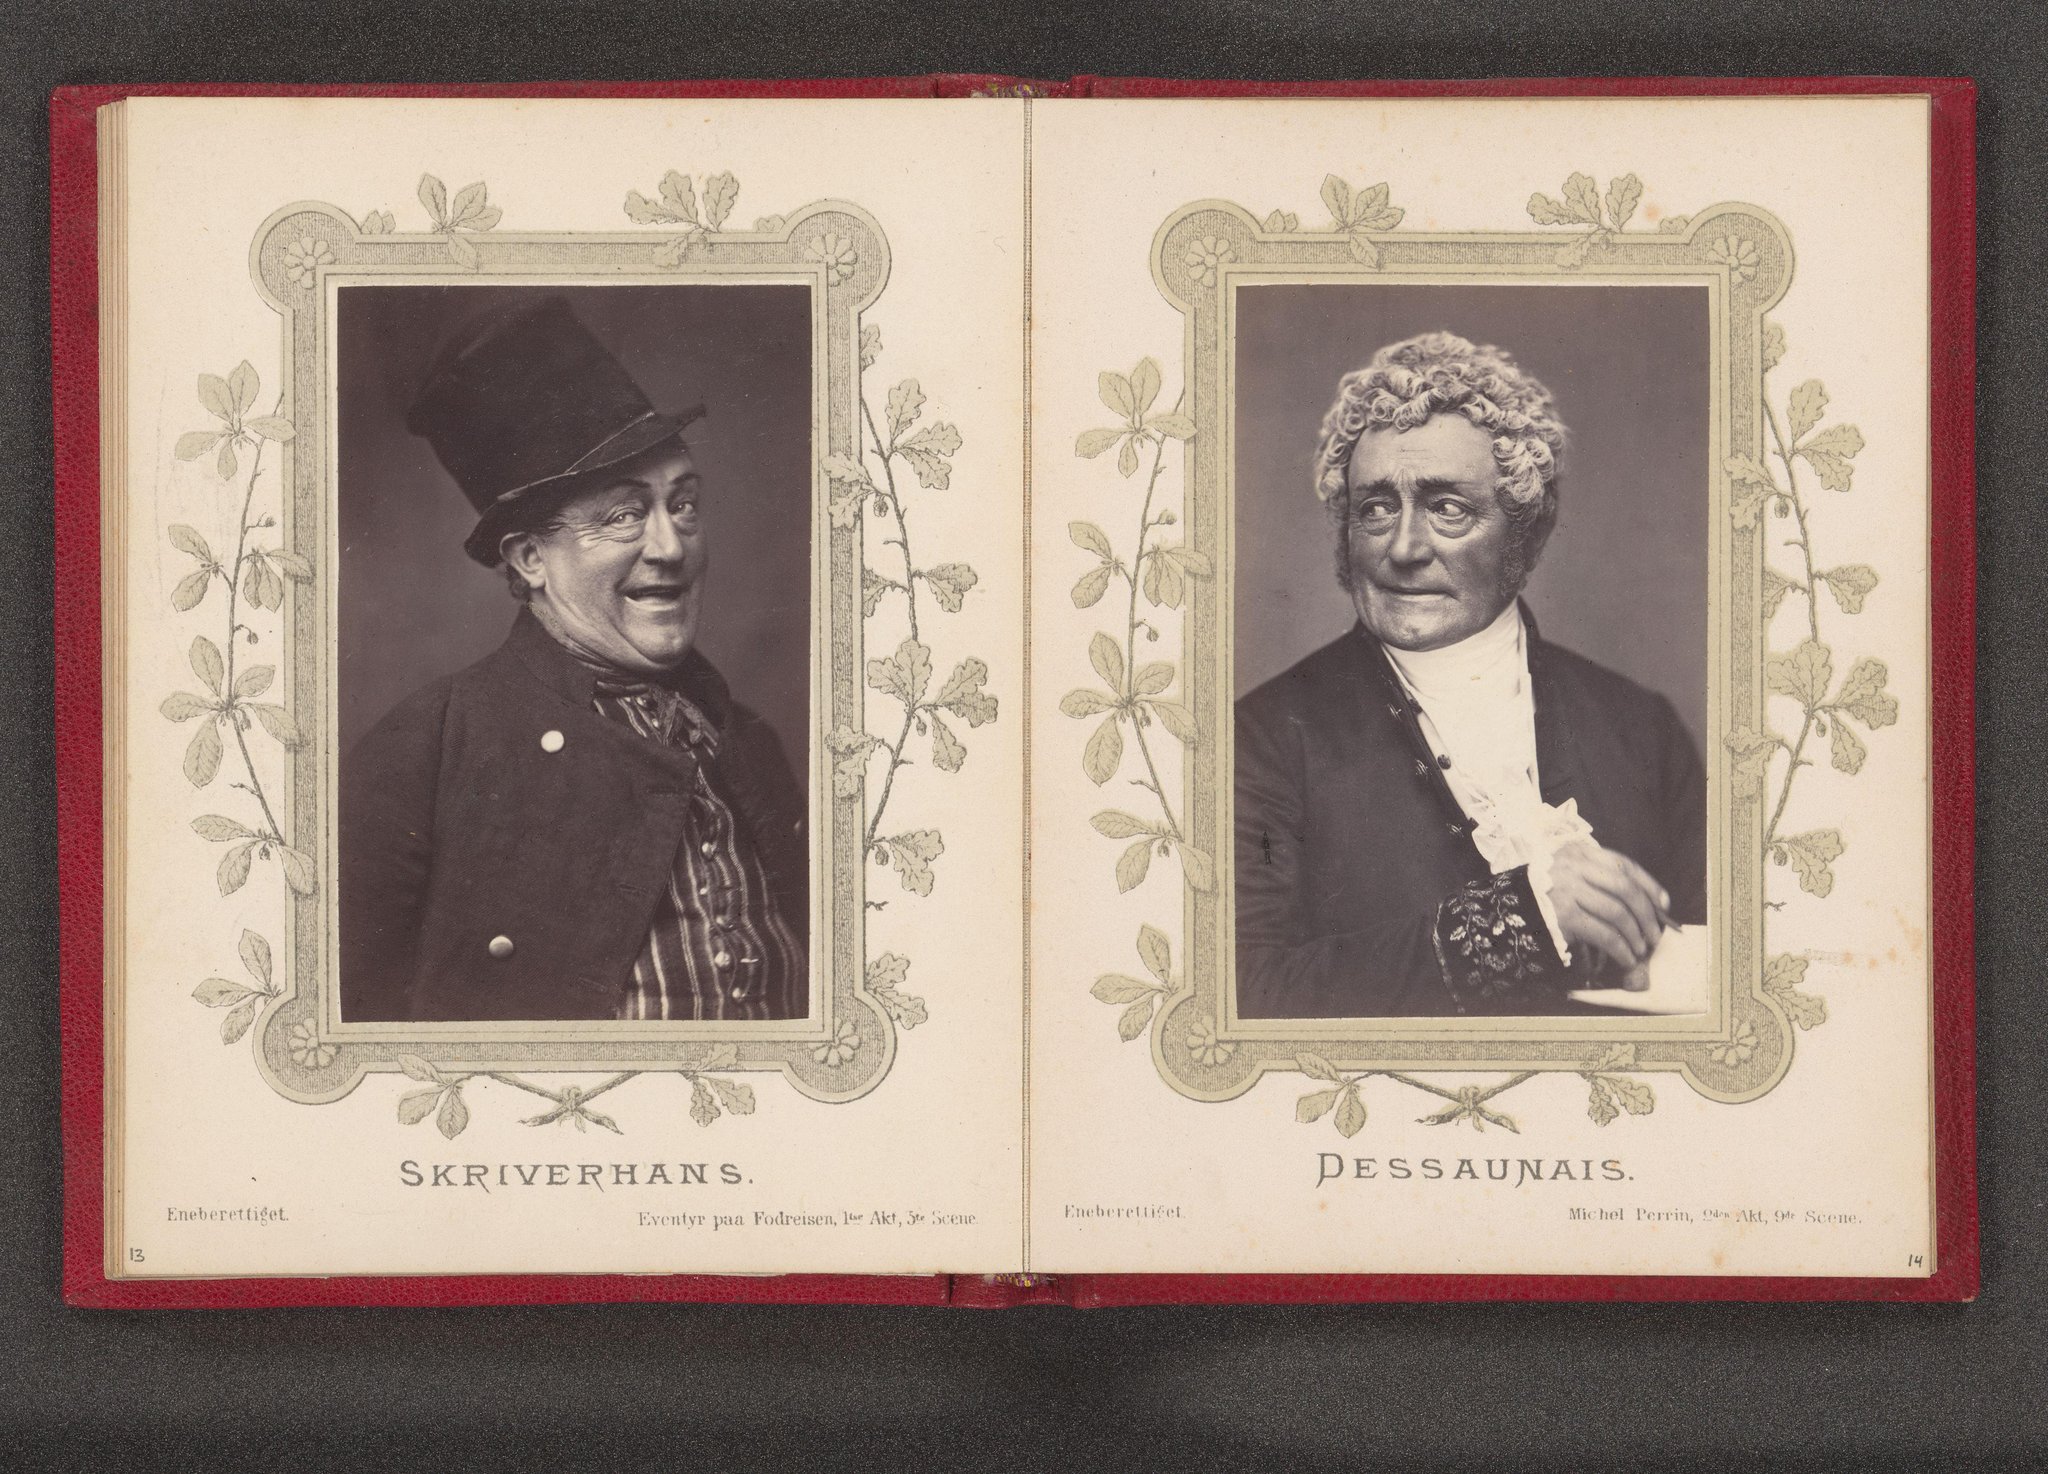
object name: page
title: Portret van Joachim Ludvig Phister als een schrijver uit Eventyr paa fodreisen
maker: harald paetz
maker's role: fotograaf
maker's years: 1837-1895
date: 1862-1872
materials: photographic support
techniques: albumen print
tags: stage costume, portrait of actor, actress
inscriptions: inscription: ‘Eneberettiget Eventyr paa fodreisen, 1ste Akt, 3de Scene.’